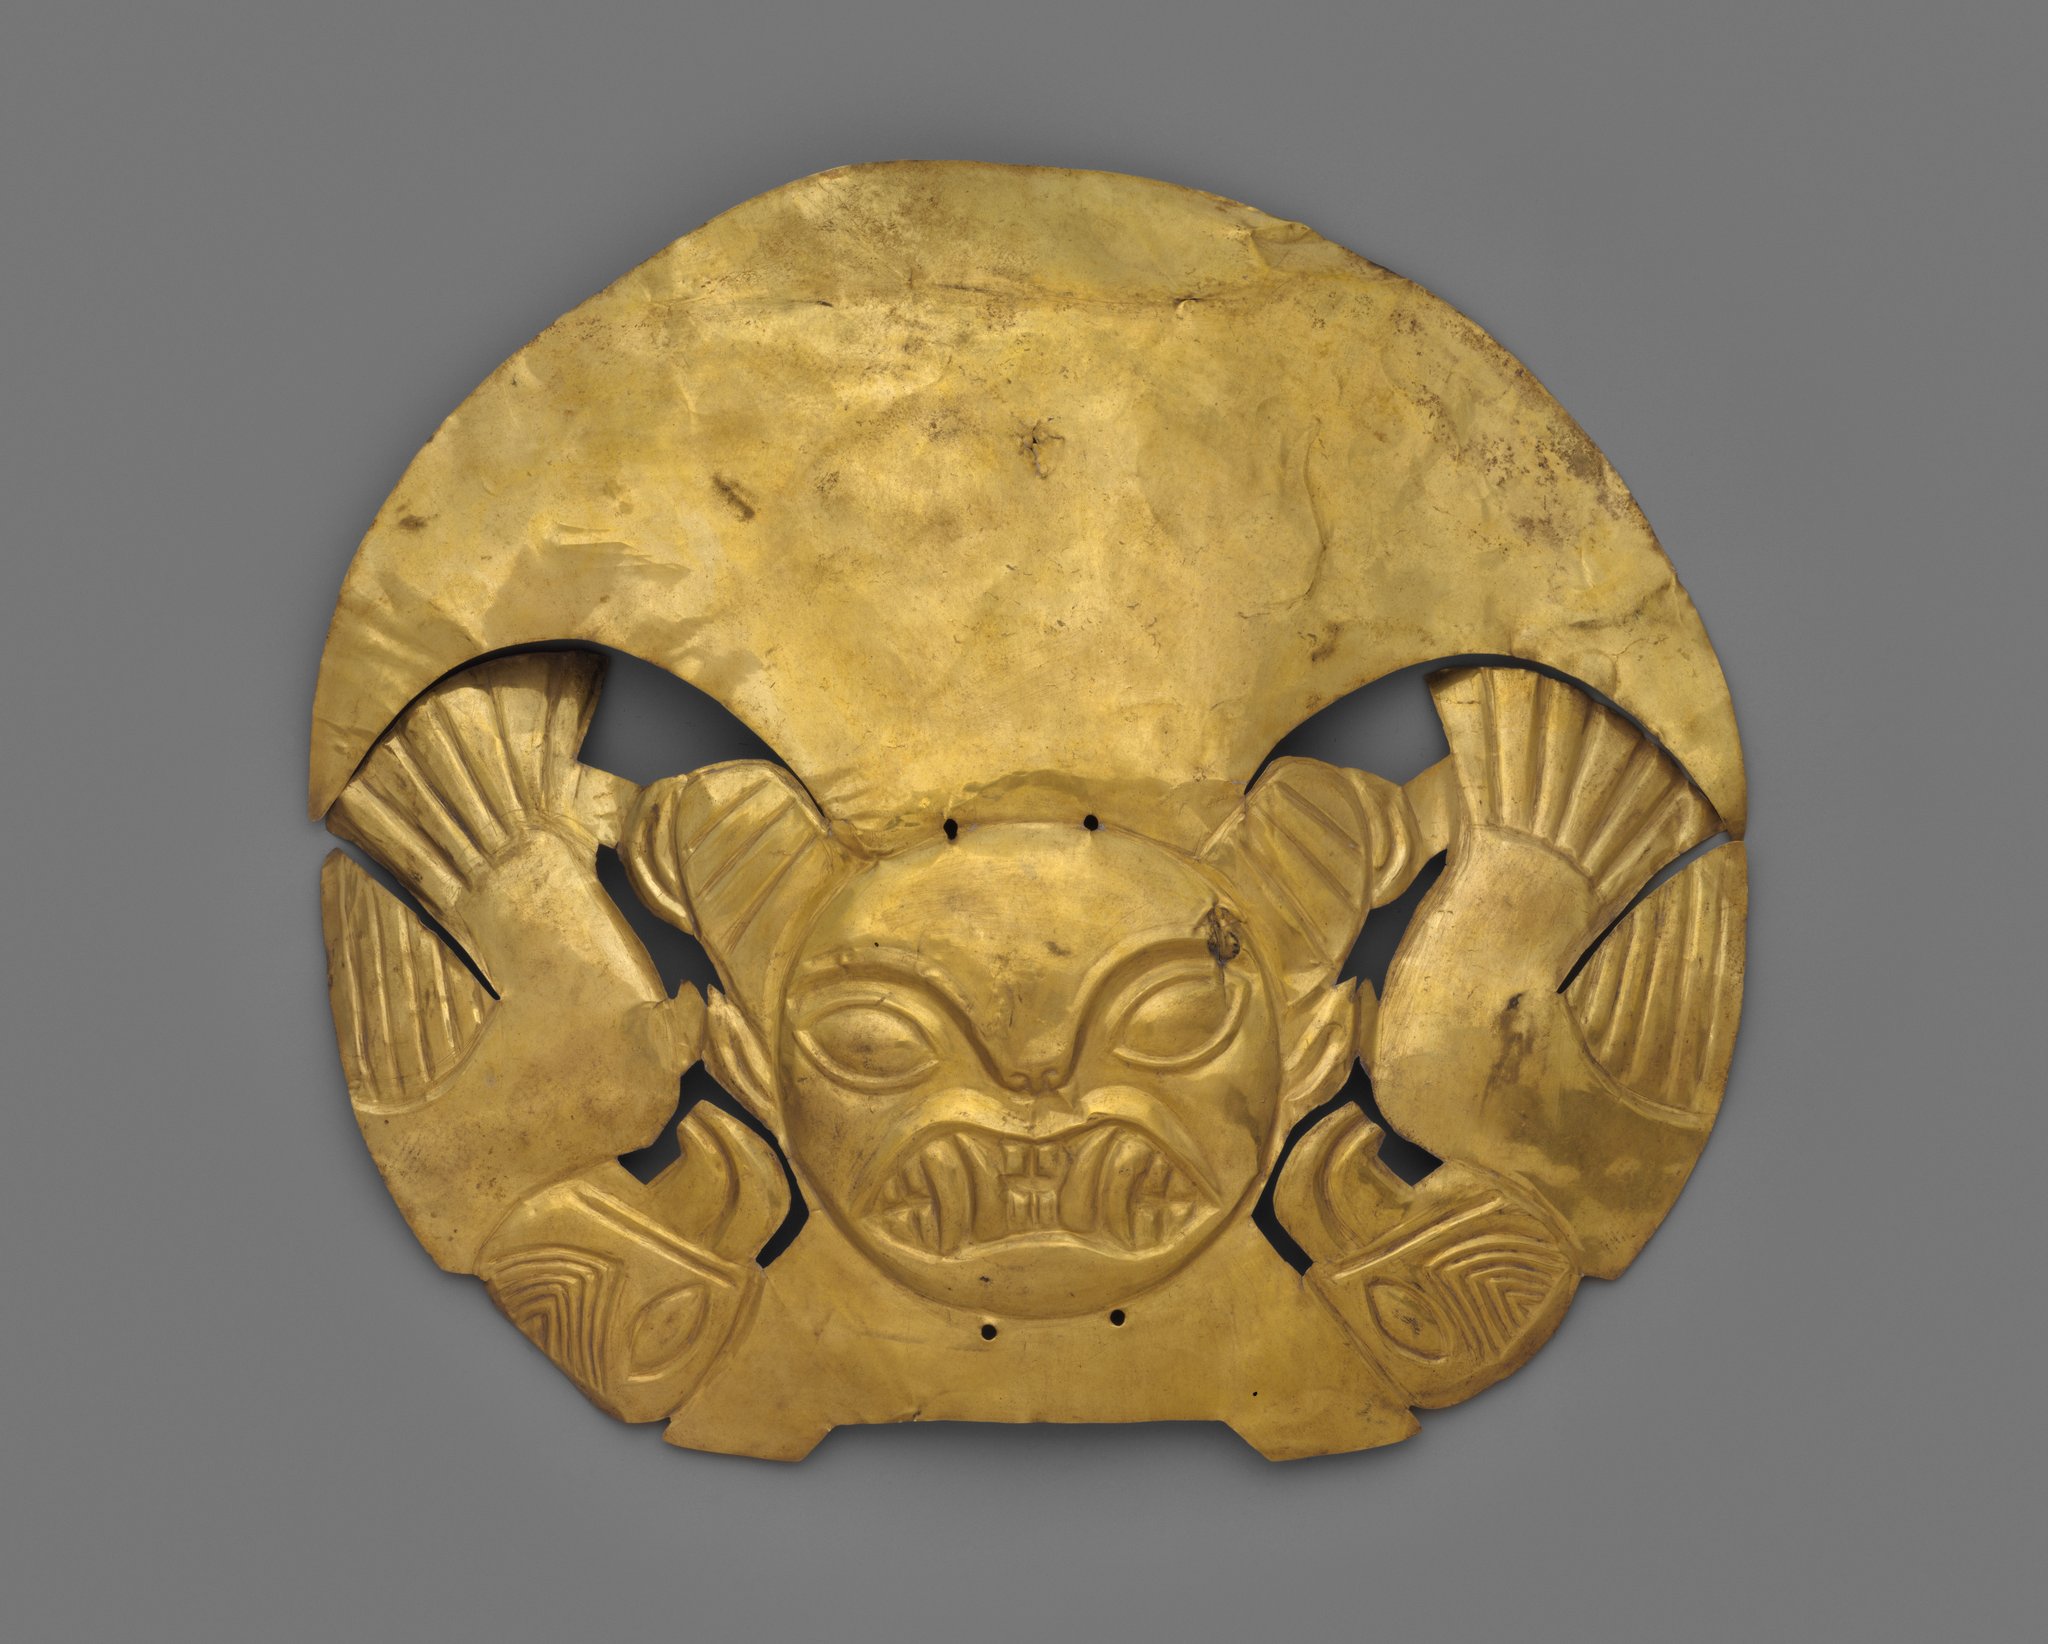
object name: ornament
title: Headdress Ornament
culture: moche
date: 200-600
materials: gold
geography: peru